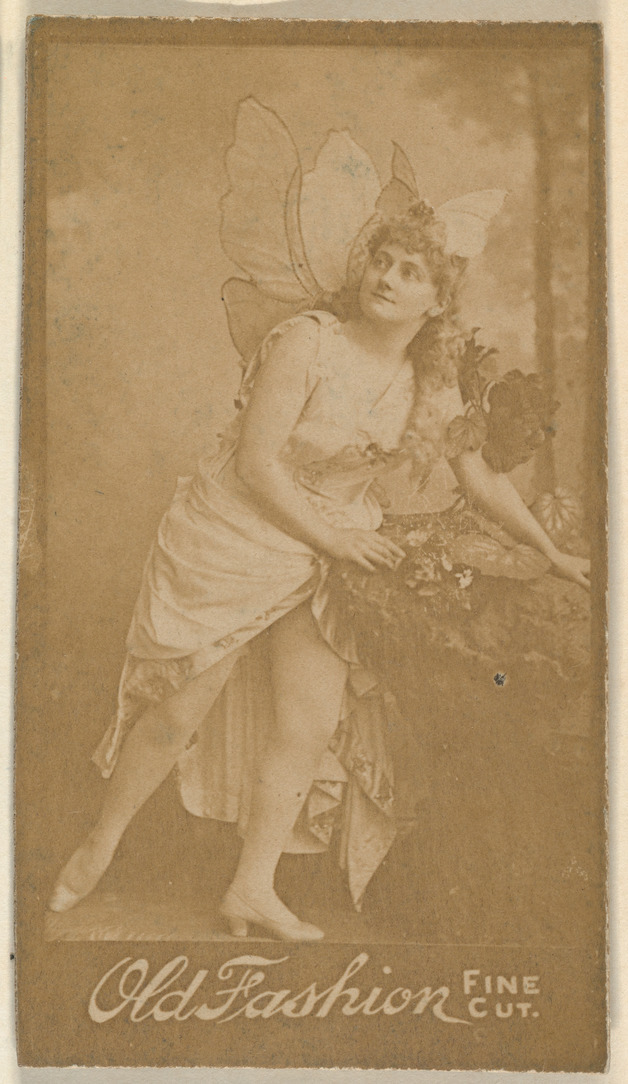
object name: photograph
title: Actress wearing costume with wings, from the Actresses series (N664) promoting Old Fashion Fine Cut Tobacco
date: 1888-1890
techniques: albumen silver print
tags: portraits,women,actresses